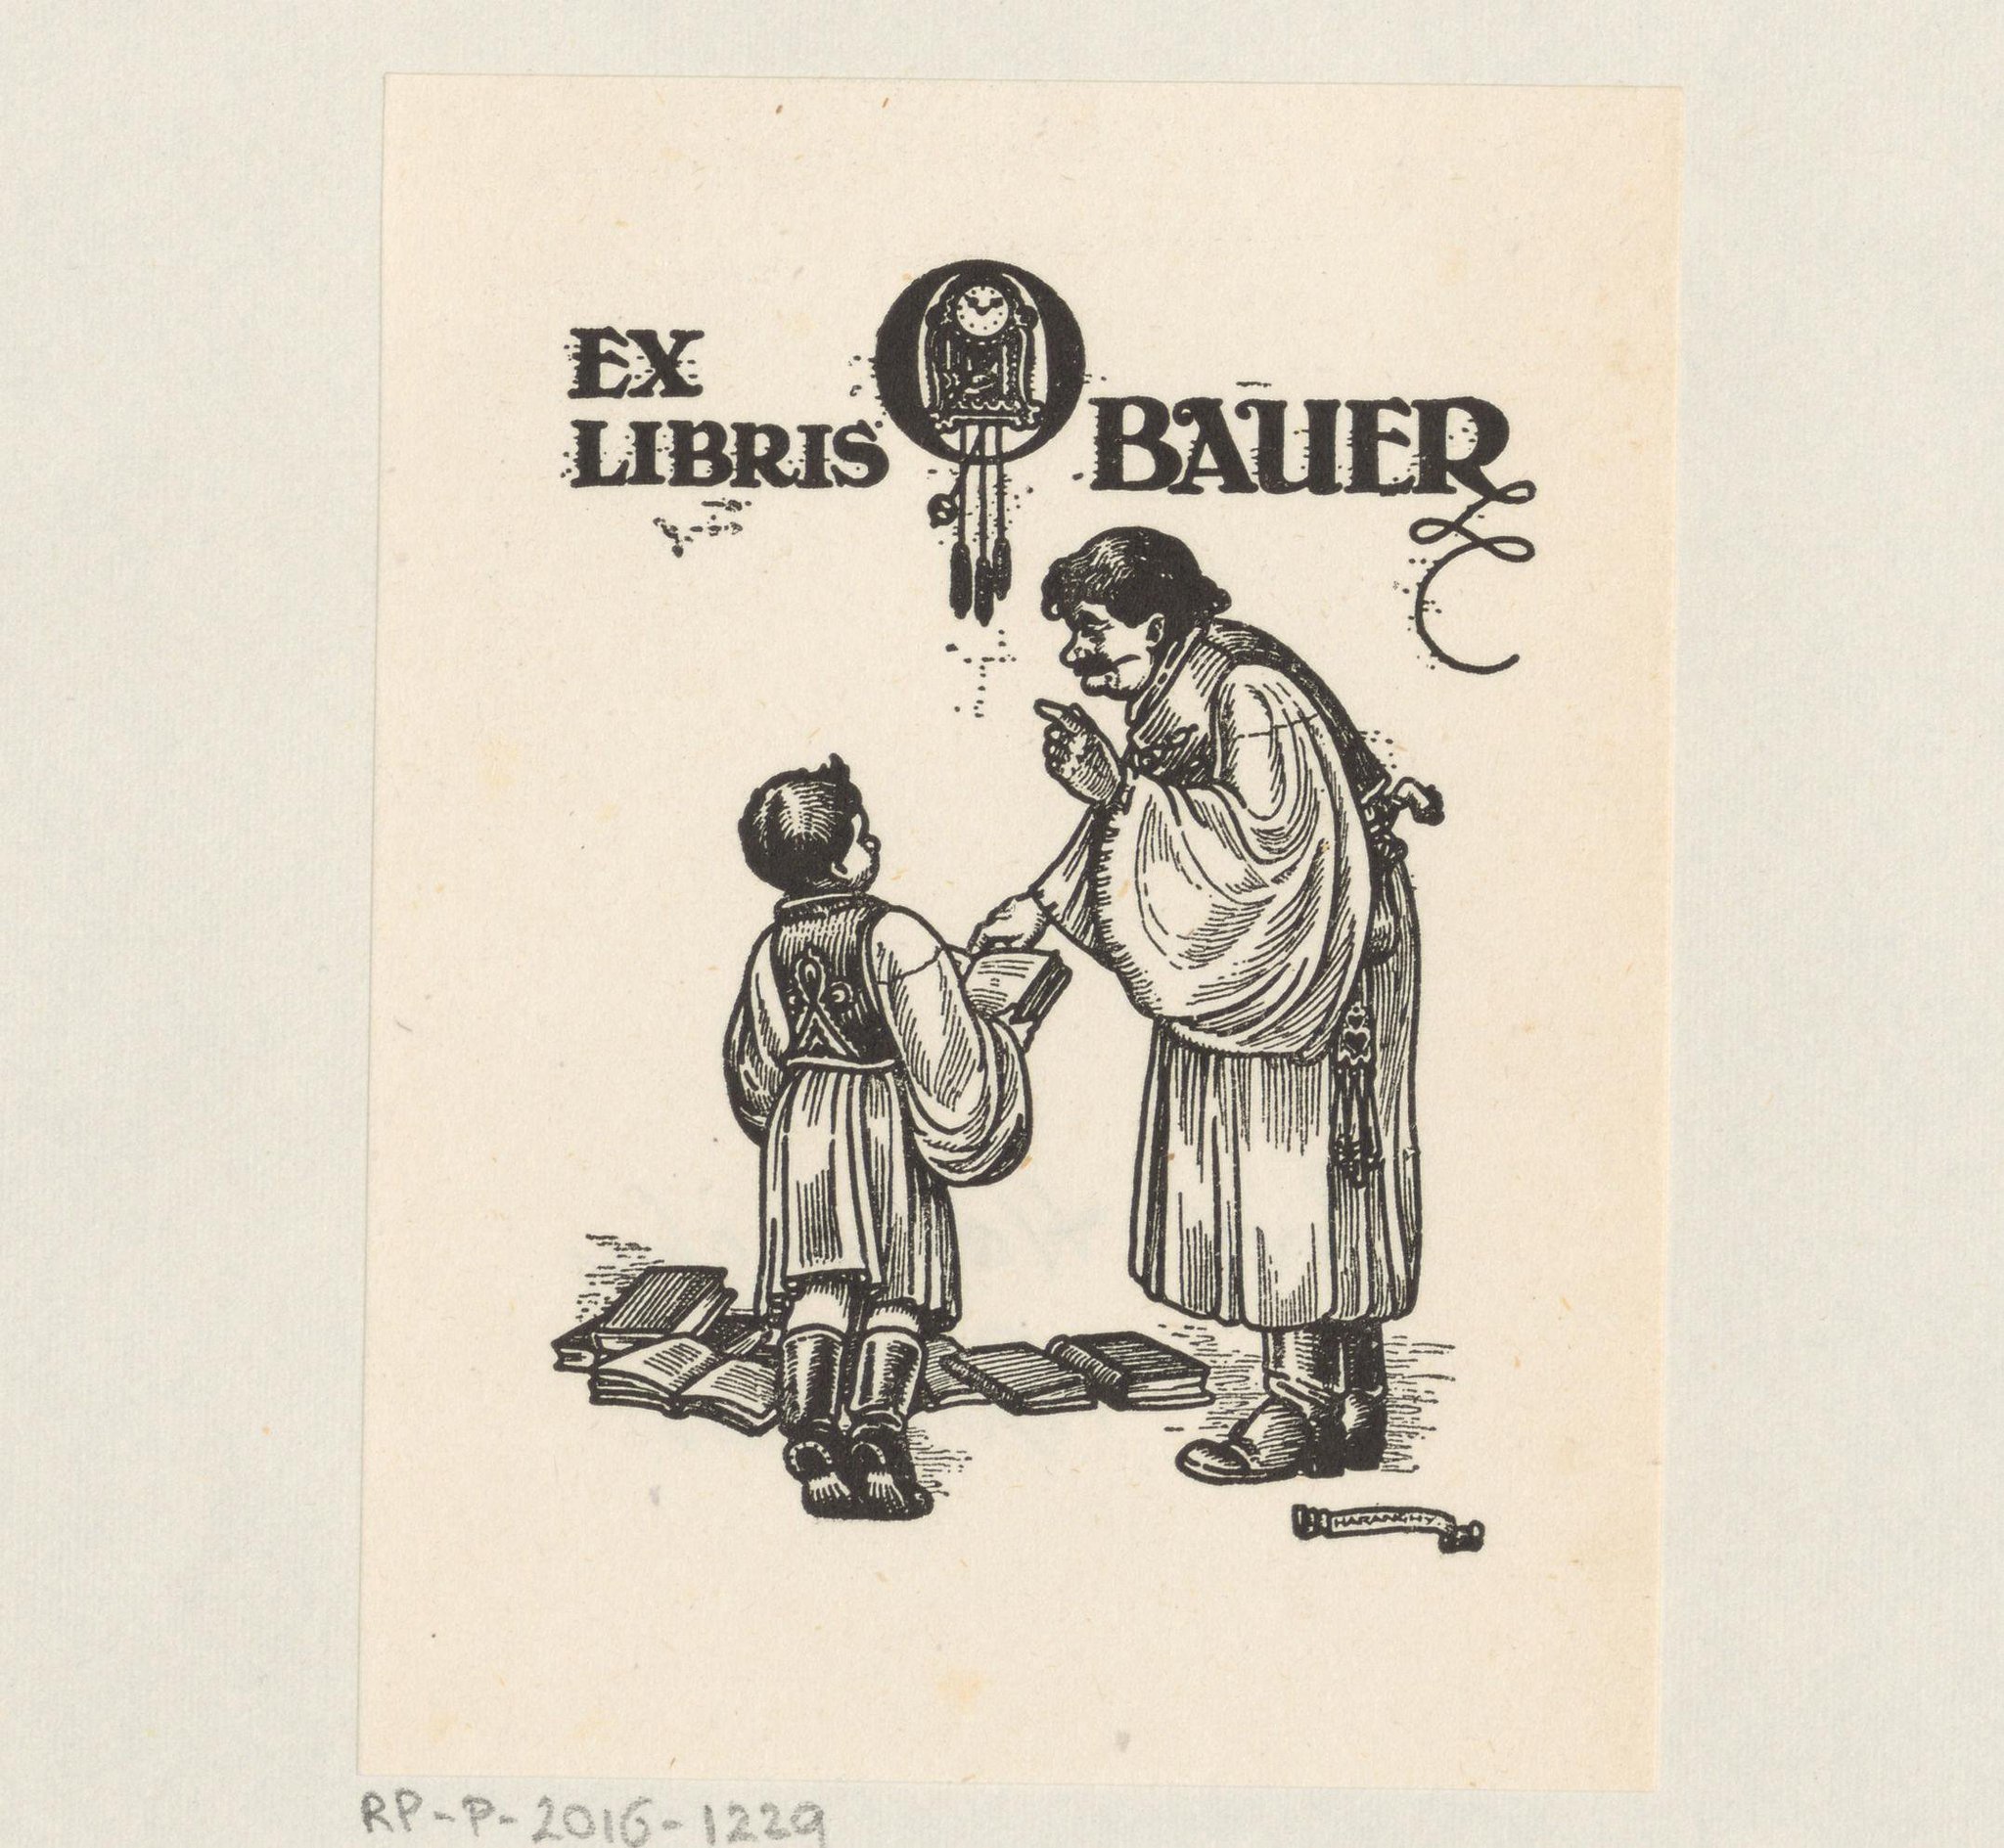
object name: bookplate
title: Ex libris van O. Bauer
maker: jenö haranghy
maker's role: print maker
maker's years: 1894-1951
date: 1904-1951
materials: paper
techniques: printing block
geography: hungary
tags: teacher and pupil